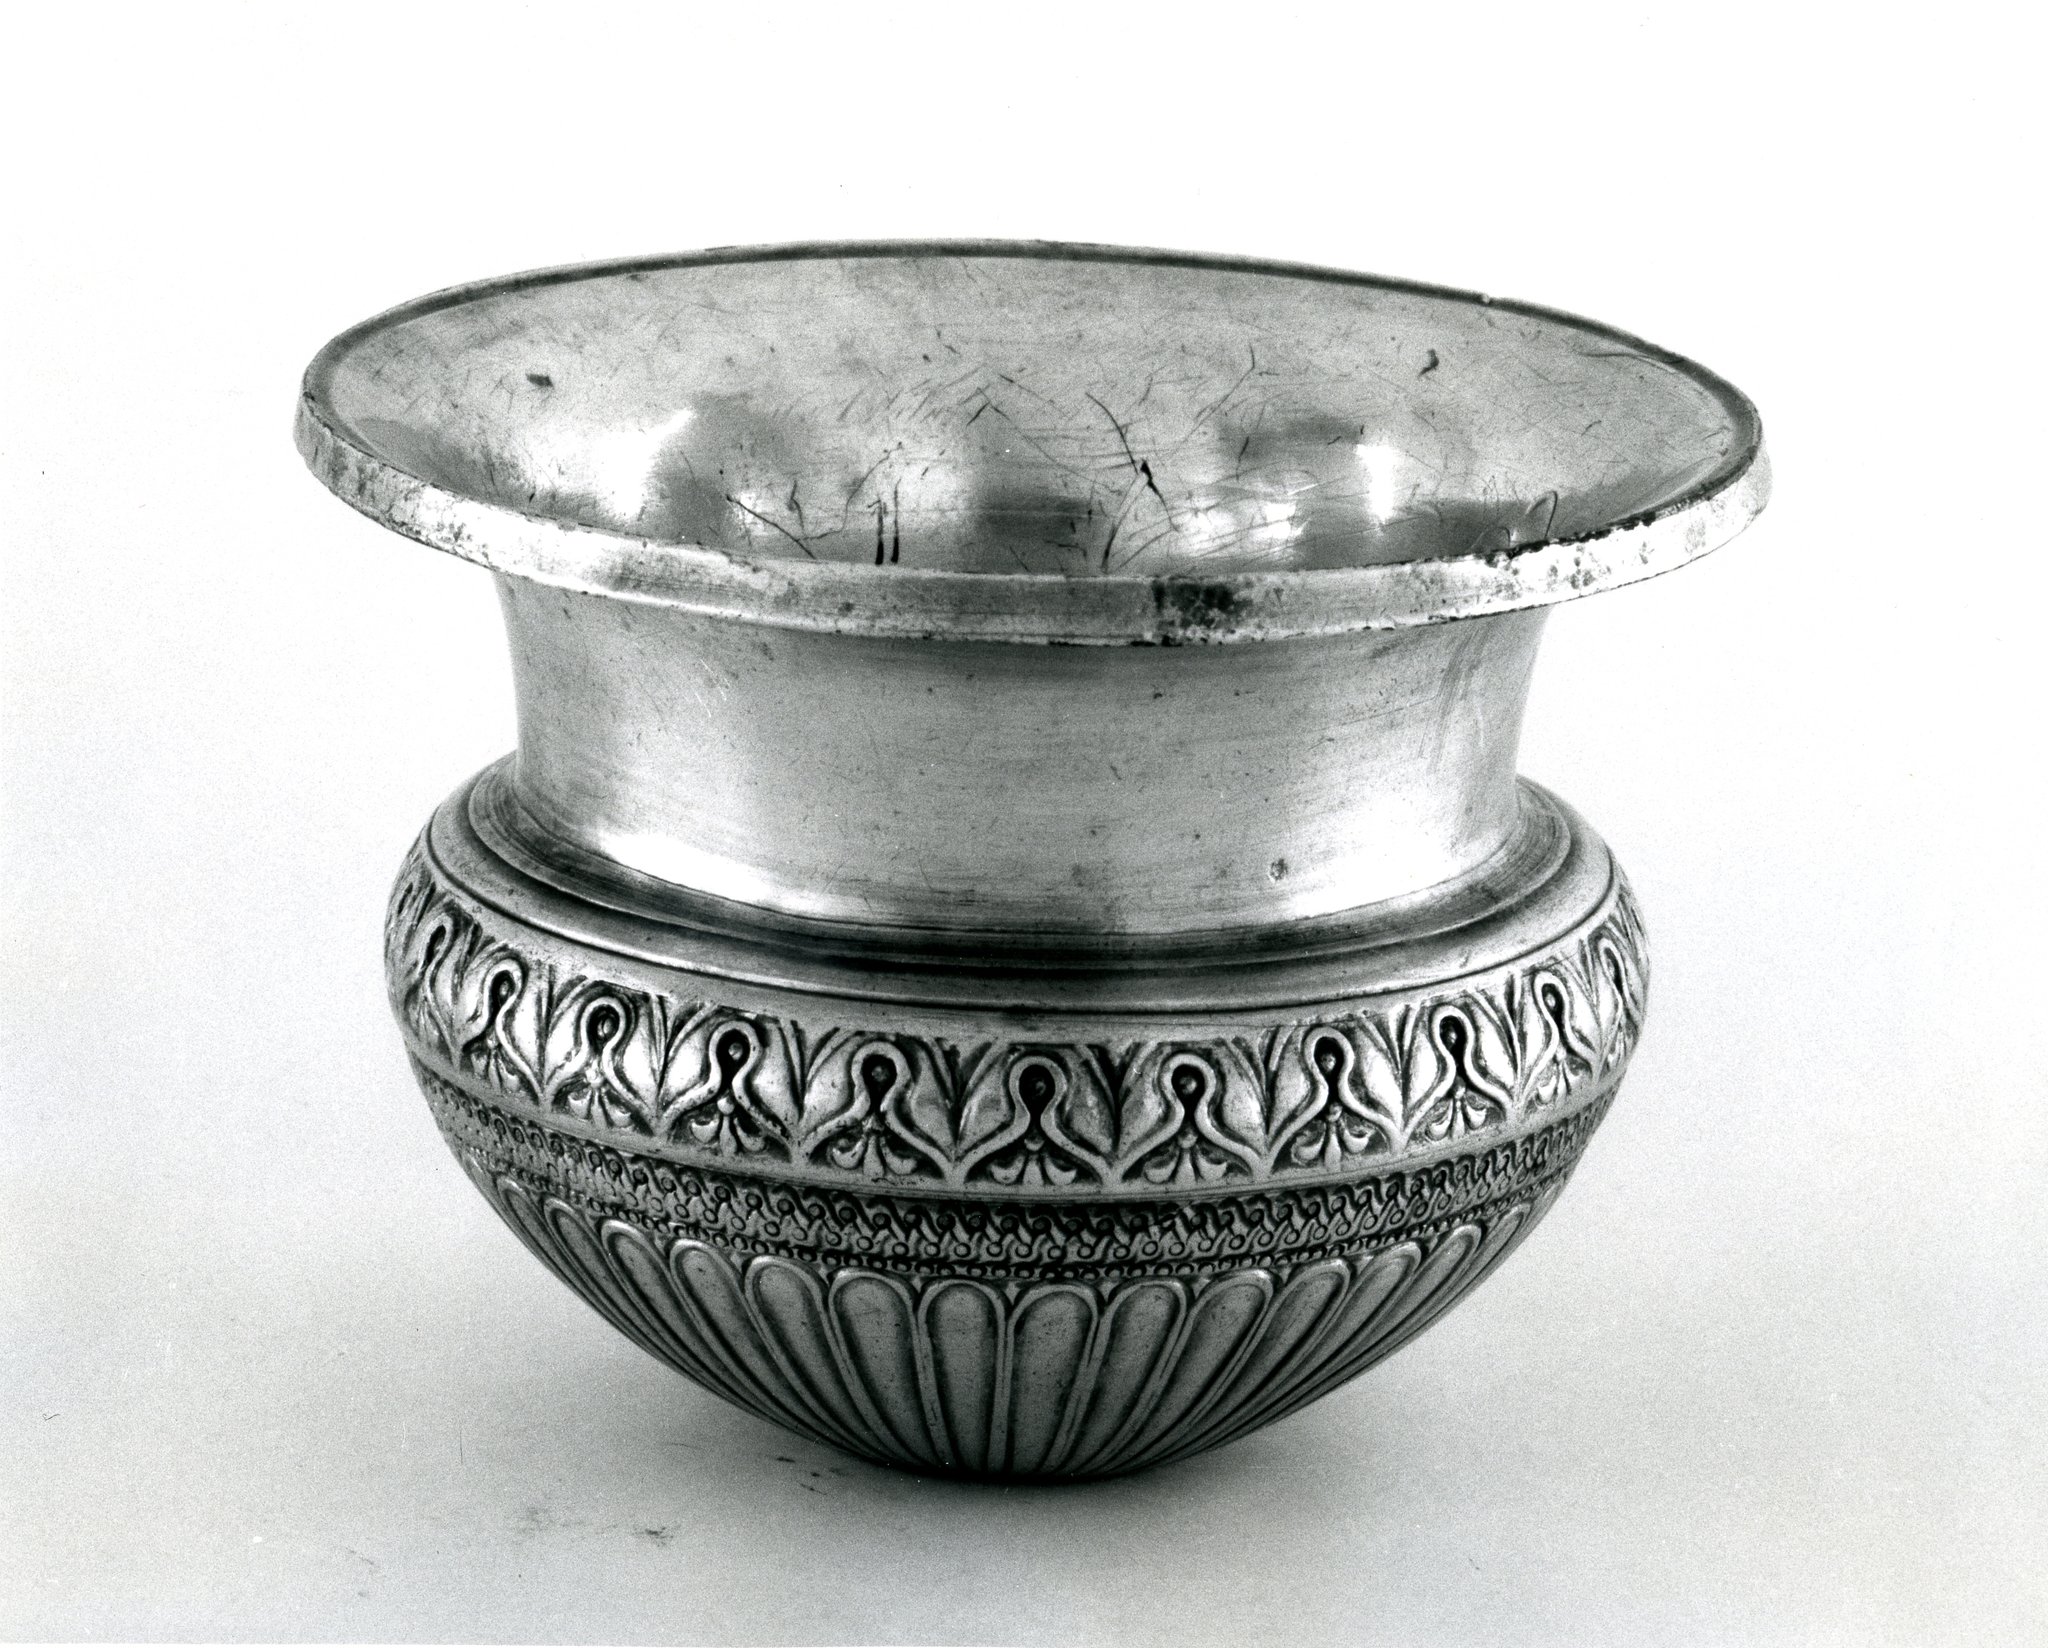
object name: cup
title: Silver cup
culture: greek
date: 334-301 BCE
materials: gold, silver